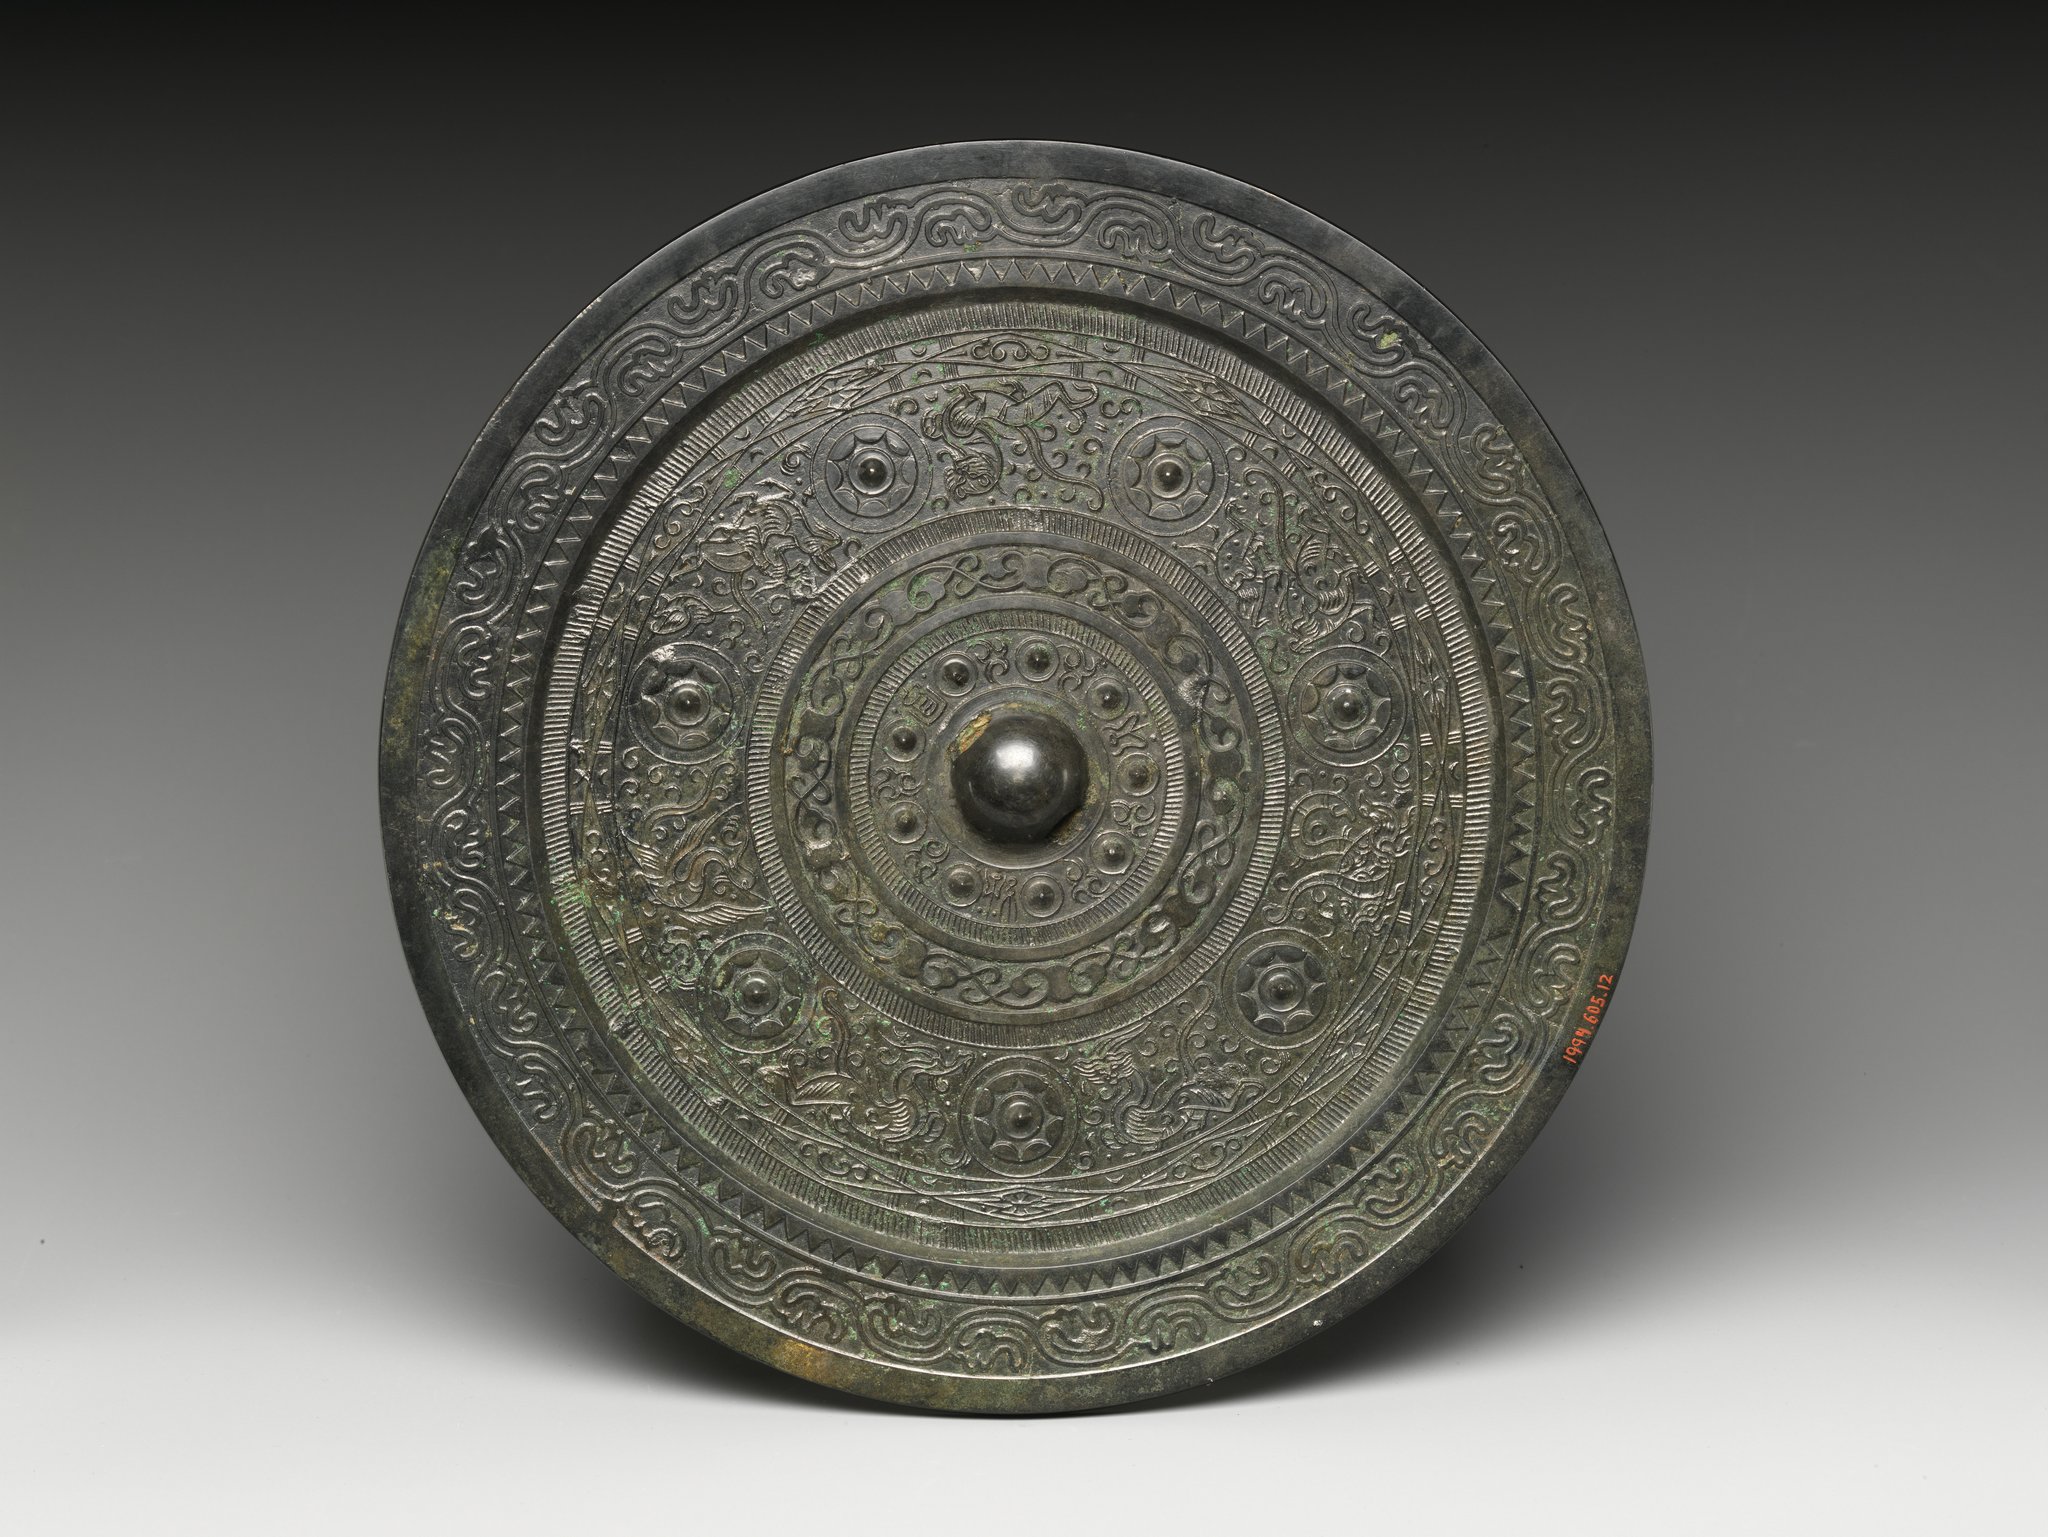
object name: mirror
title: Mirror with animals of the four directions and other mythical creatures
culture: chinese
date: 1-200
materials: bronze